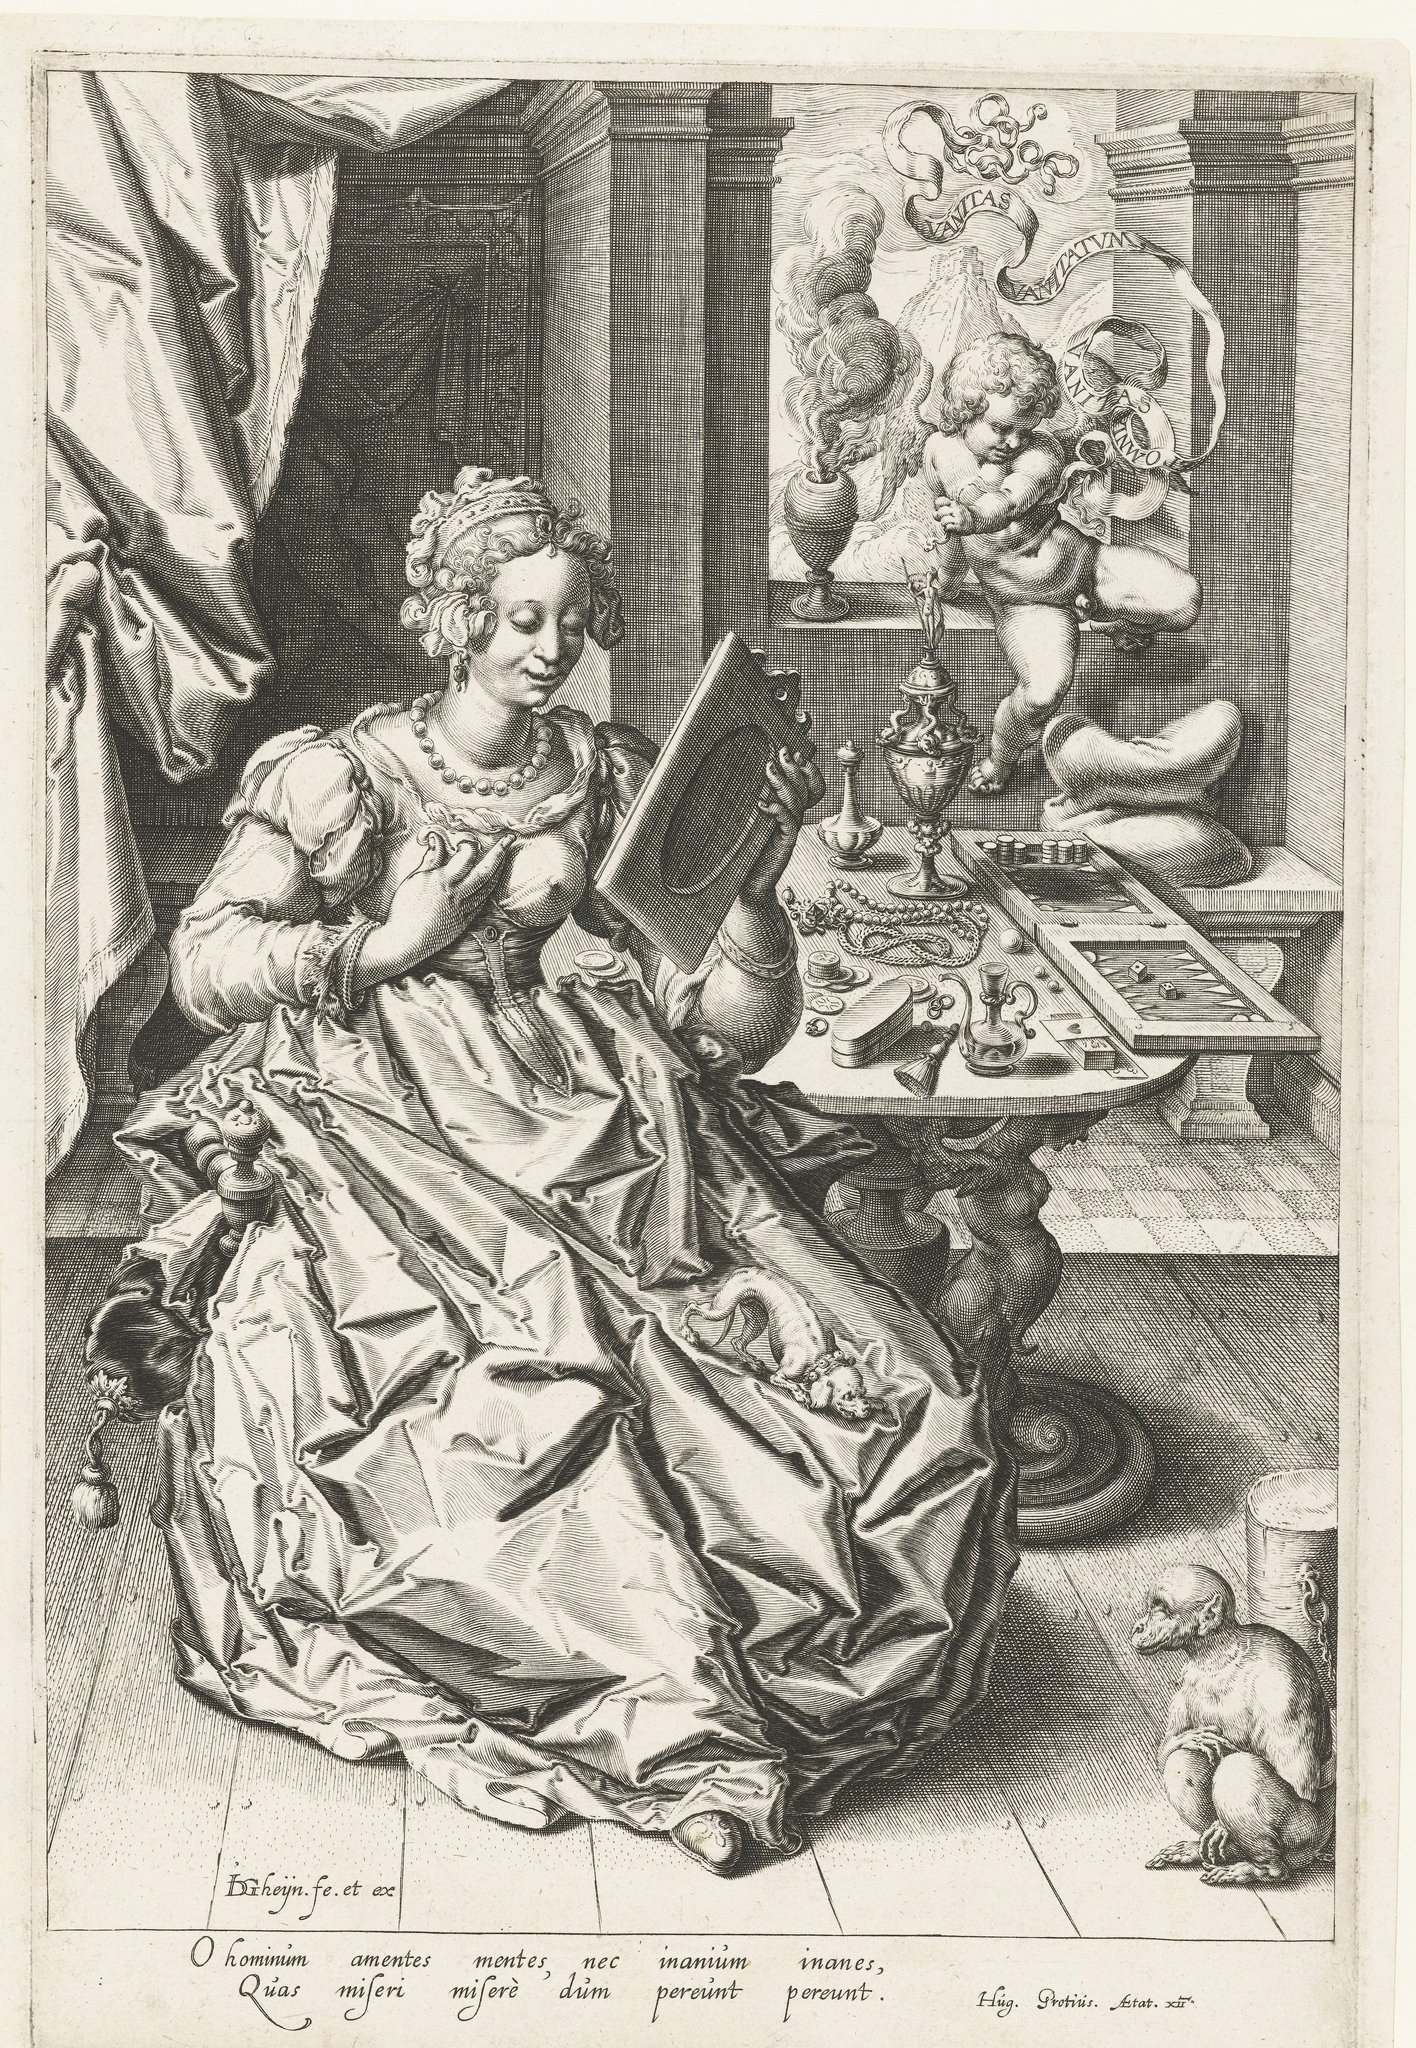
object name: print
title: Allegorie op de ijdelheid (jongedame met spiegel en putto)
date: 1595-1596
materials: paper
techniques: engraving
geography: netherlands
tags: 'vanitas' symbols, (woman) looking in a mirror ~ scene symbolizing 'vanitas'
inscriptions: collector's mark: Lugt 2760, collector's mark: Lugt 2228a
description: Vanitasvoorstelling in de vorm van een vrouw, gehuld in kostbare kleding, zichzelf bewonderend in een handspiegel, op haar schoot een hondje, aan haar voeten een aapje. Op de tafel naast haar sieraden en een bordspel. Door het raam achter de dame klimt een putto naar binnen met een banderol waarop staat 'VANITAS VANITATUM, EST OMNIA VANITAS'. Onder de voorstelling twee regels tekst in Latijn.